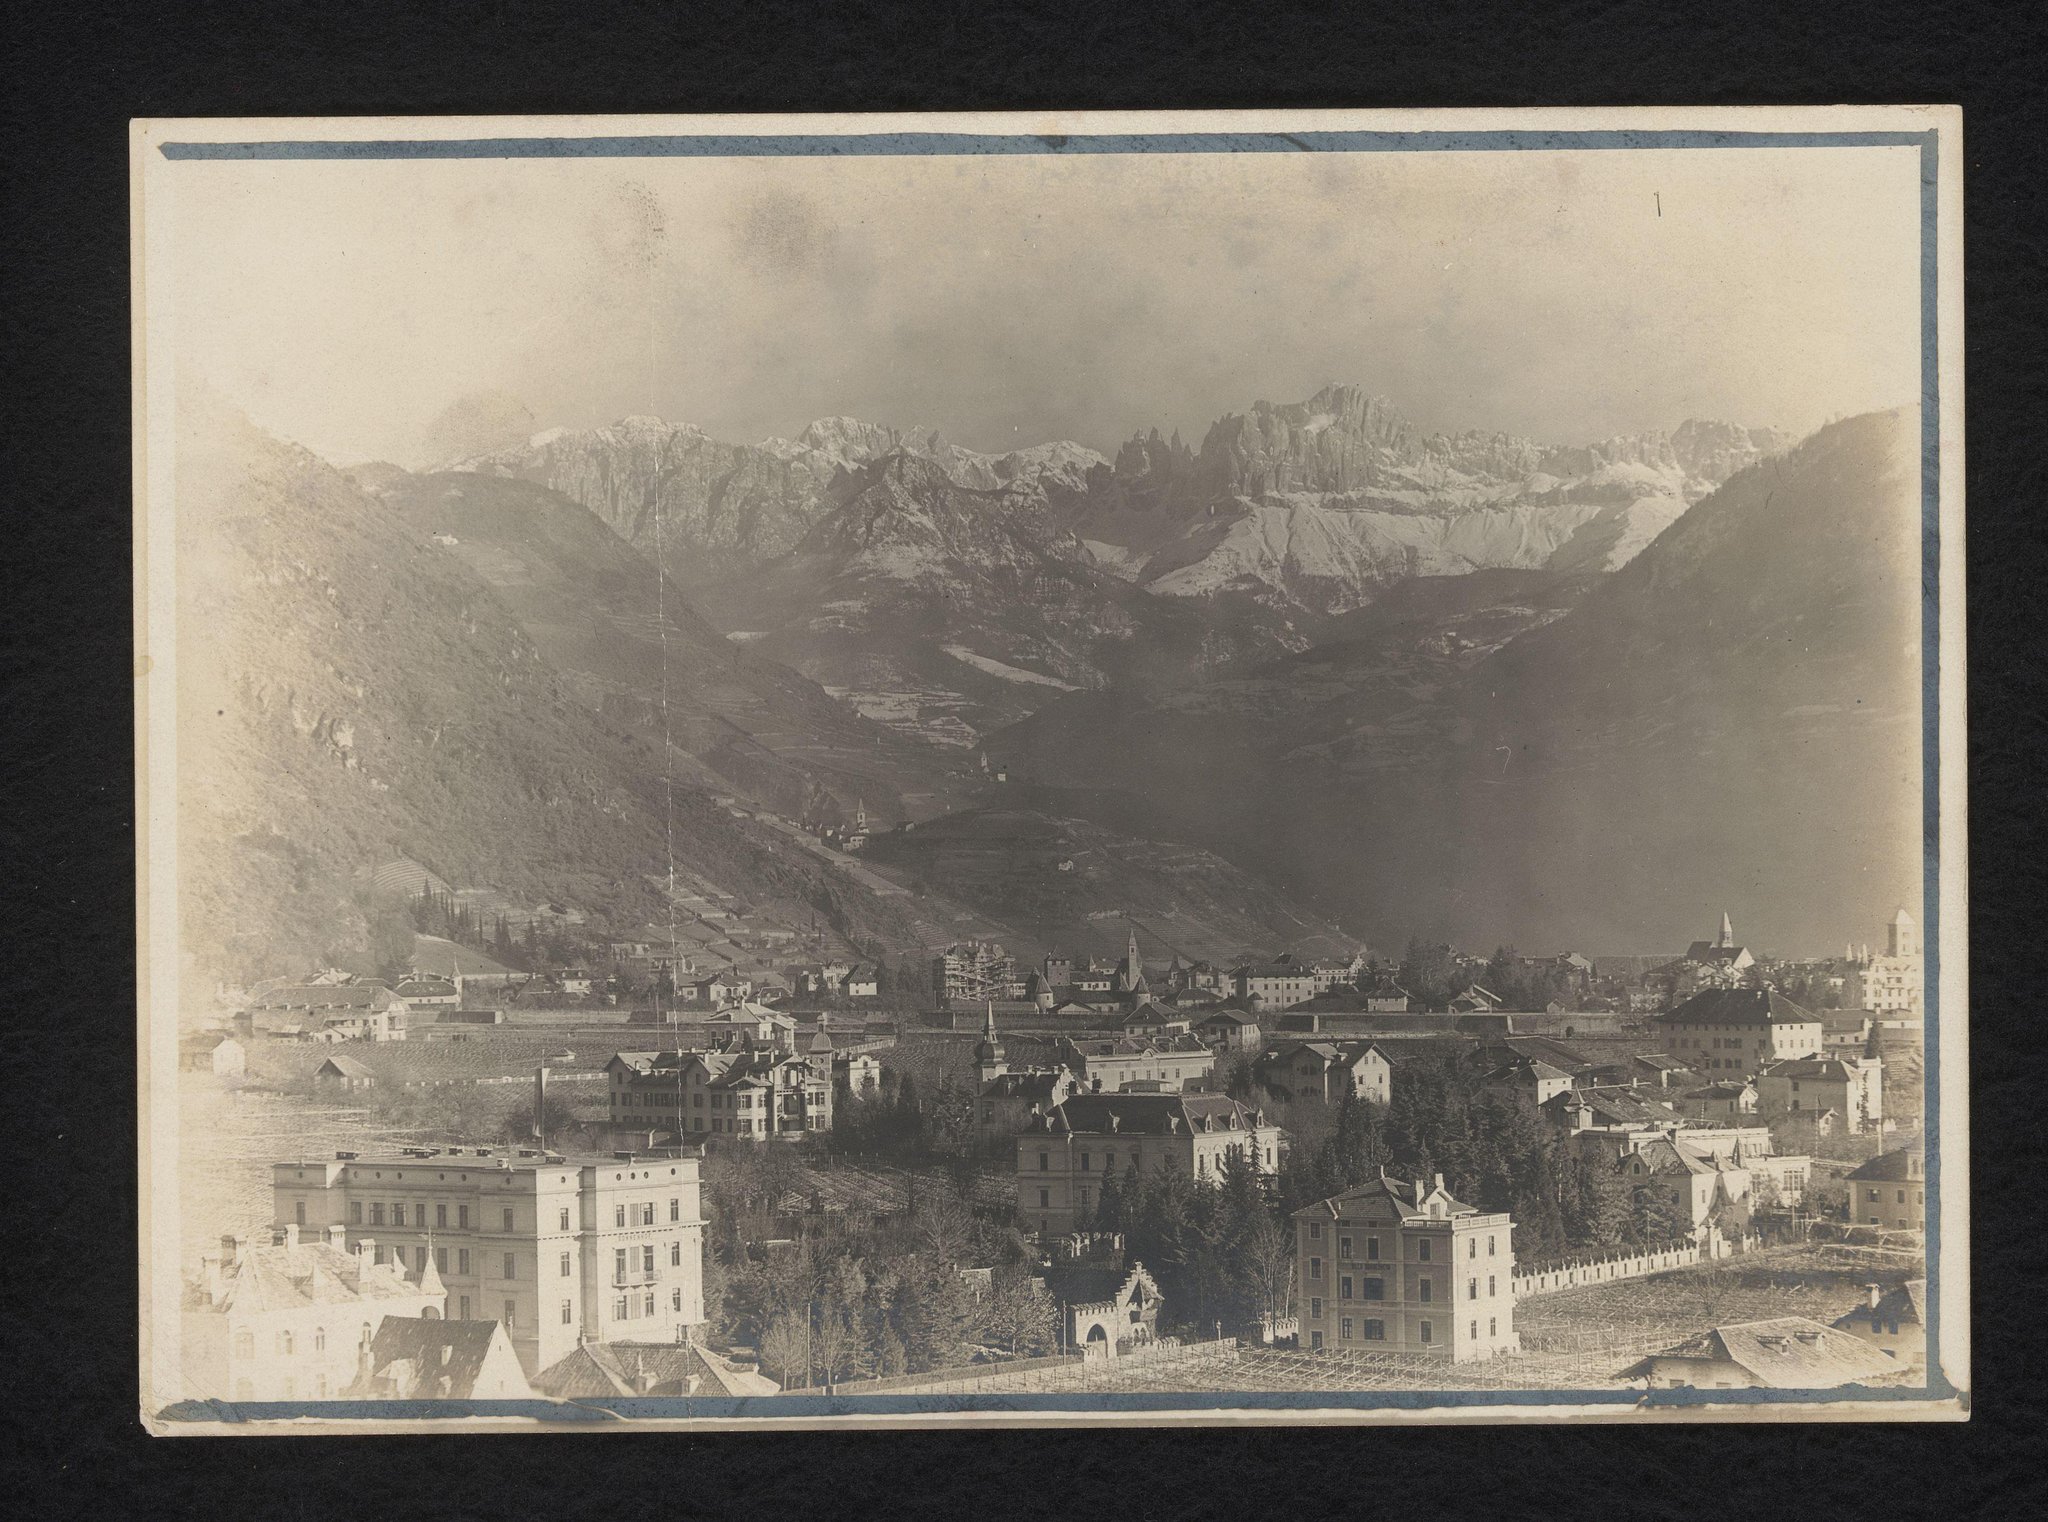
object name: photograph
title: Landschap met bergen en een stad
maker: Anonymous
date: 1880-1920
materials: cardboard, photographic support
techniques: gelatin silver print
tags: city-view, and landscape with man-made constructions, mountains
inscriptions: annotation: ‘Uit atelier Breitner’